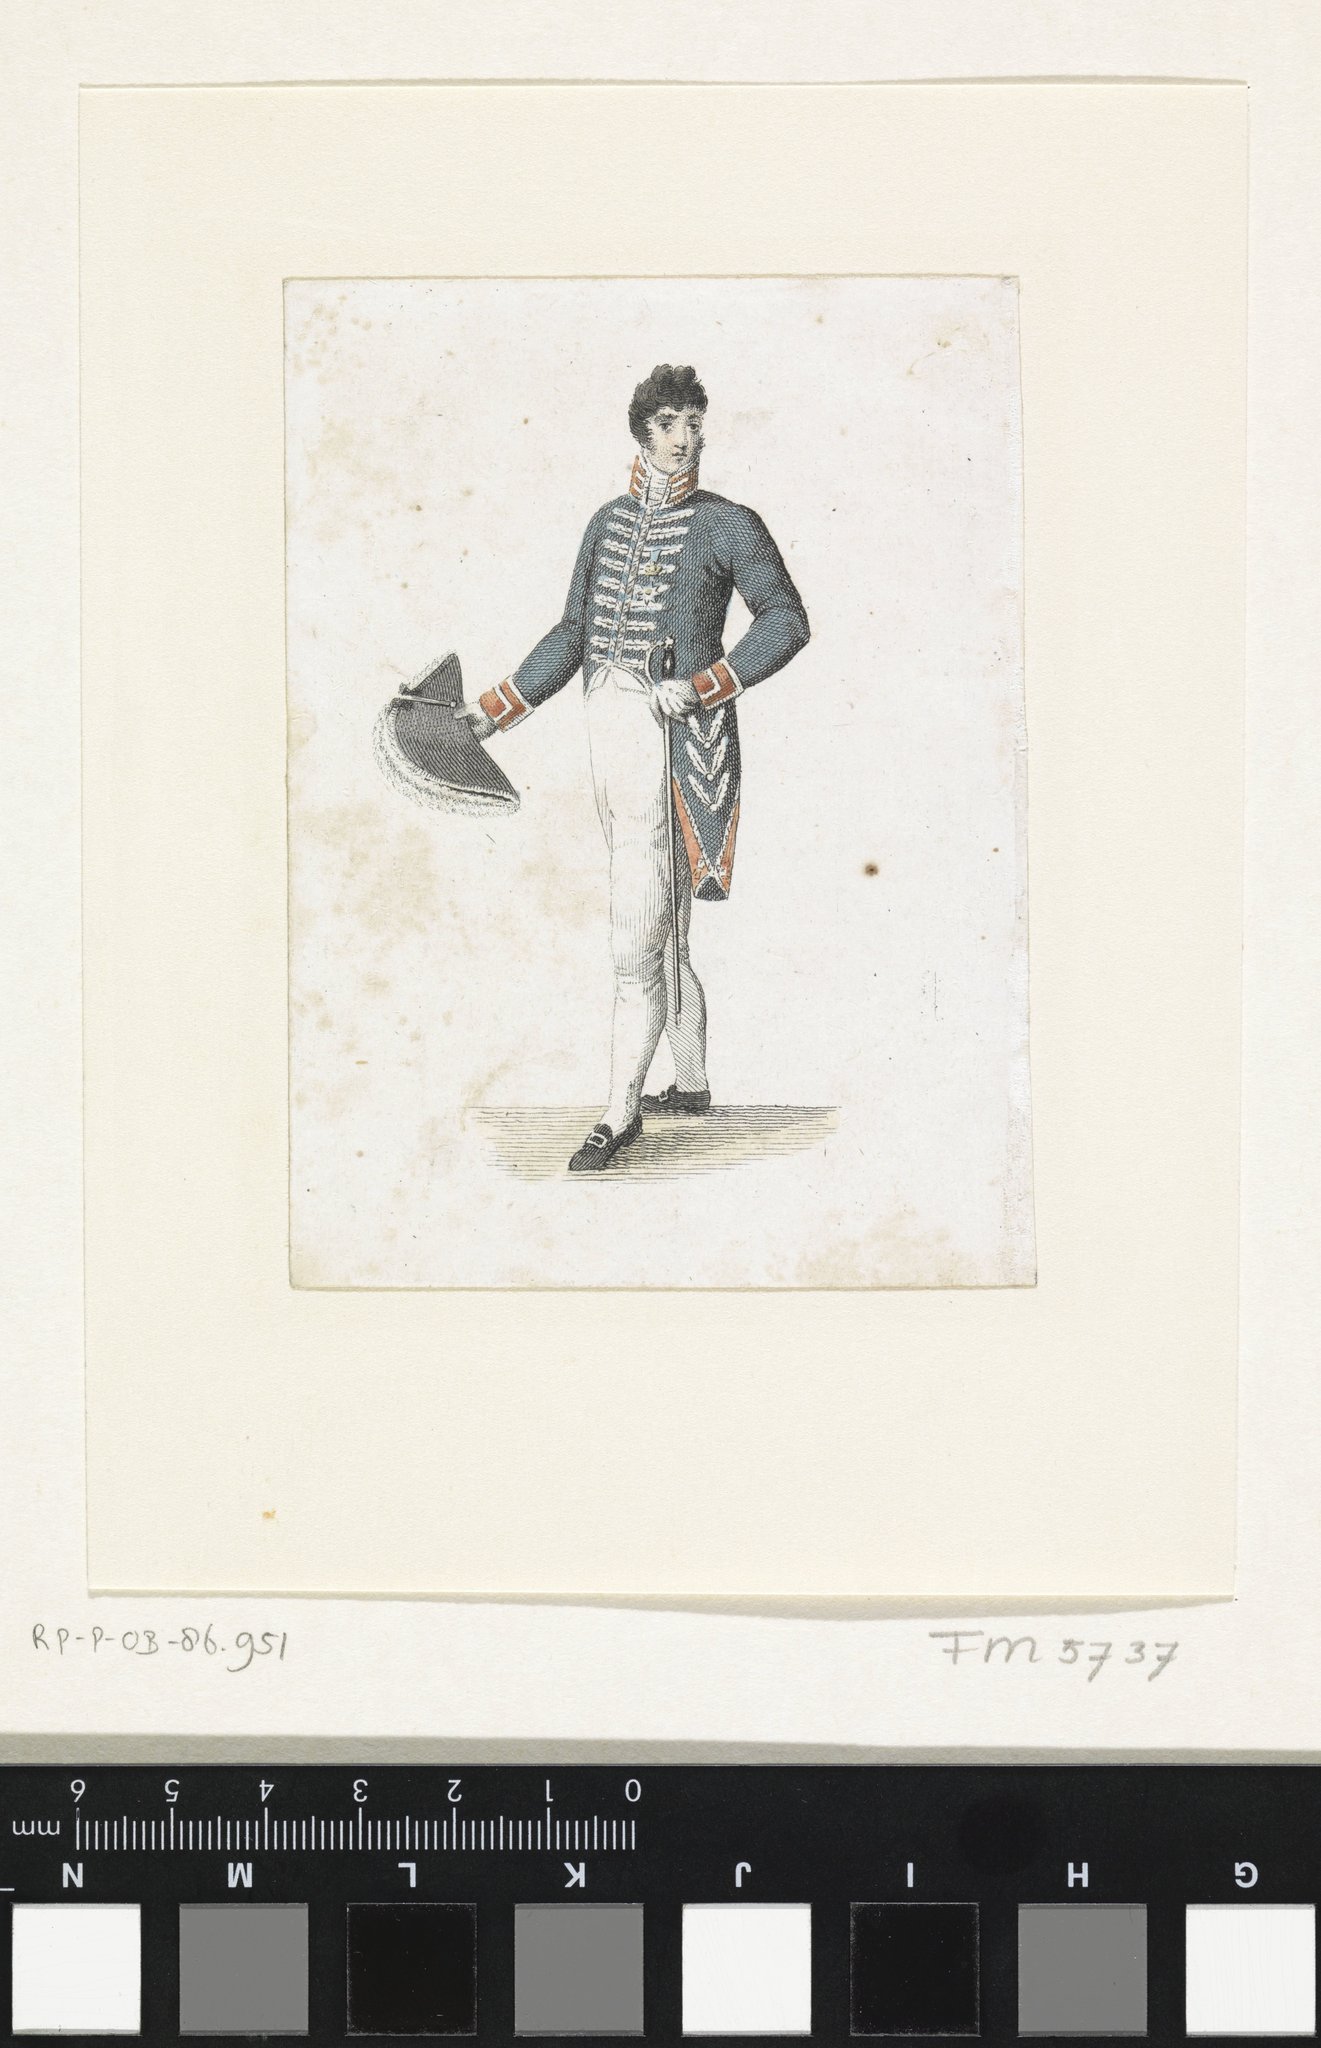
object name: print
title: Man gekleed in het kostuum van de Orde van de Unie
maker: Anonymous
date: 1807-1810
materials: paper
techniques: engraving, etching, hand coloring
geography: netherlands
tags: louis napoleon (king of holland), knighthood order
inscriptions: collector's mark: Lugt 2166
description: Man gekleed in het kostuum van de Orde van de Unie. Onderscheiding ingesteld door koning Lodewijk Napoleon, voor het eerst in 1806.